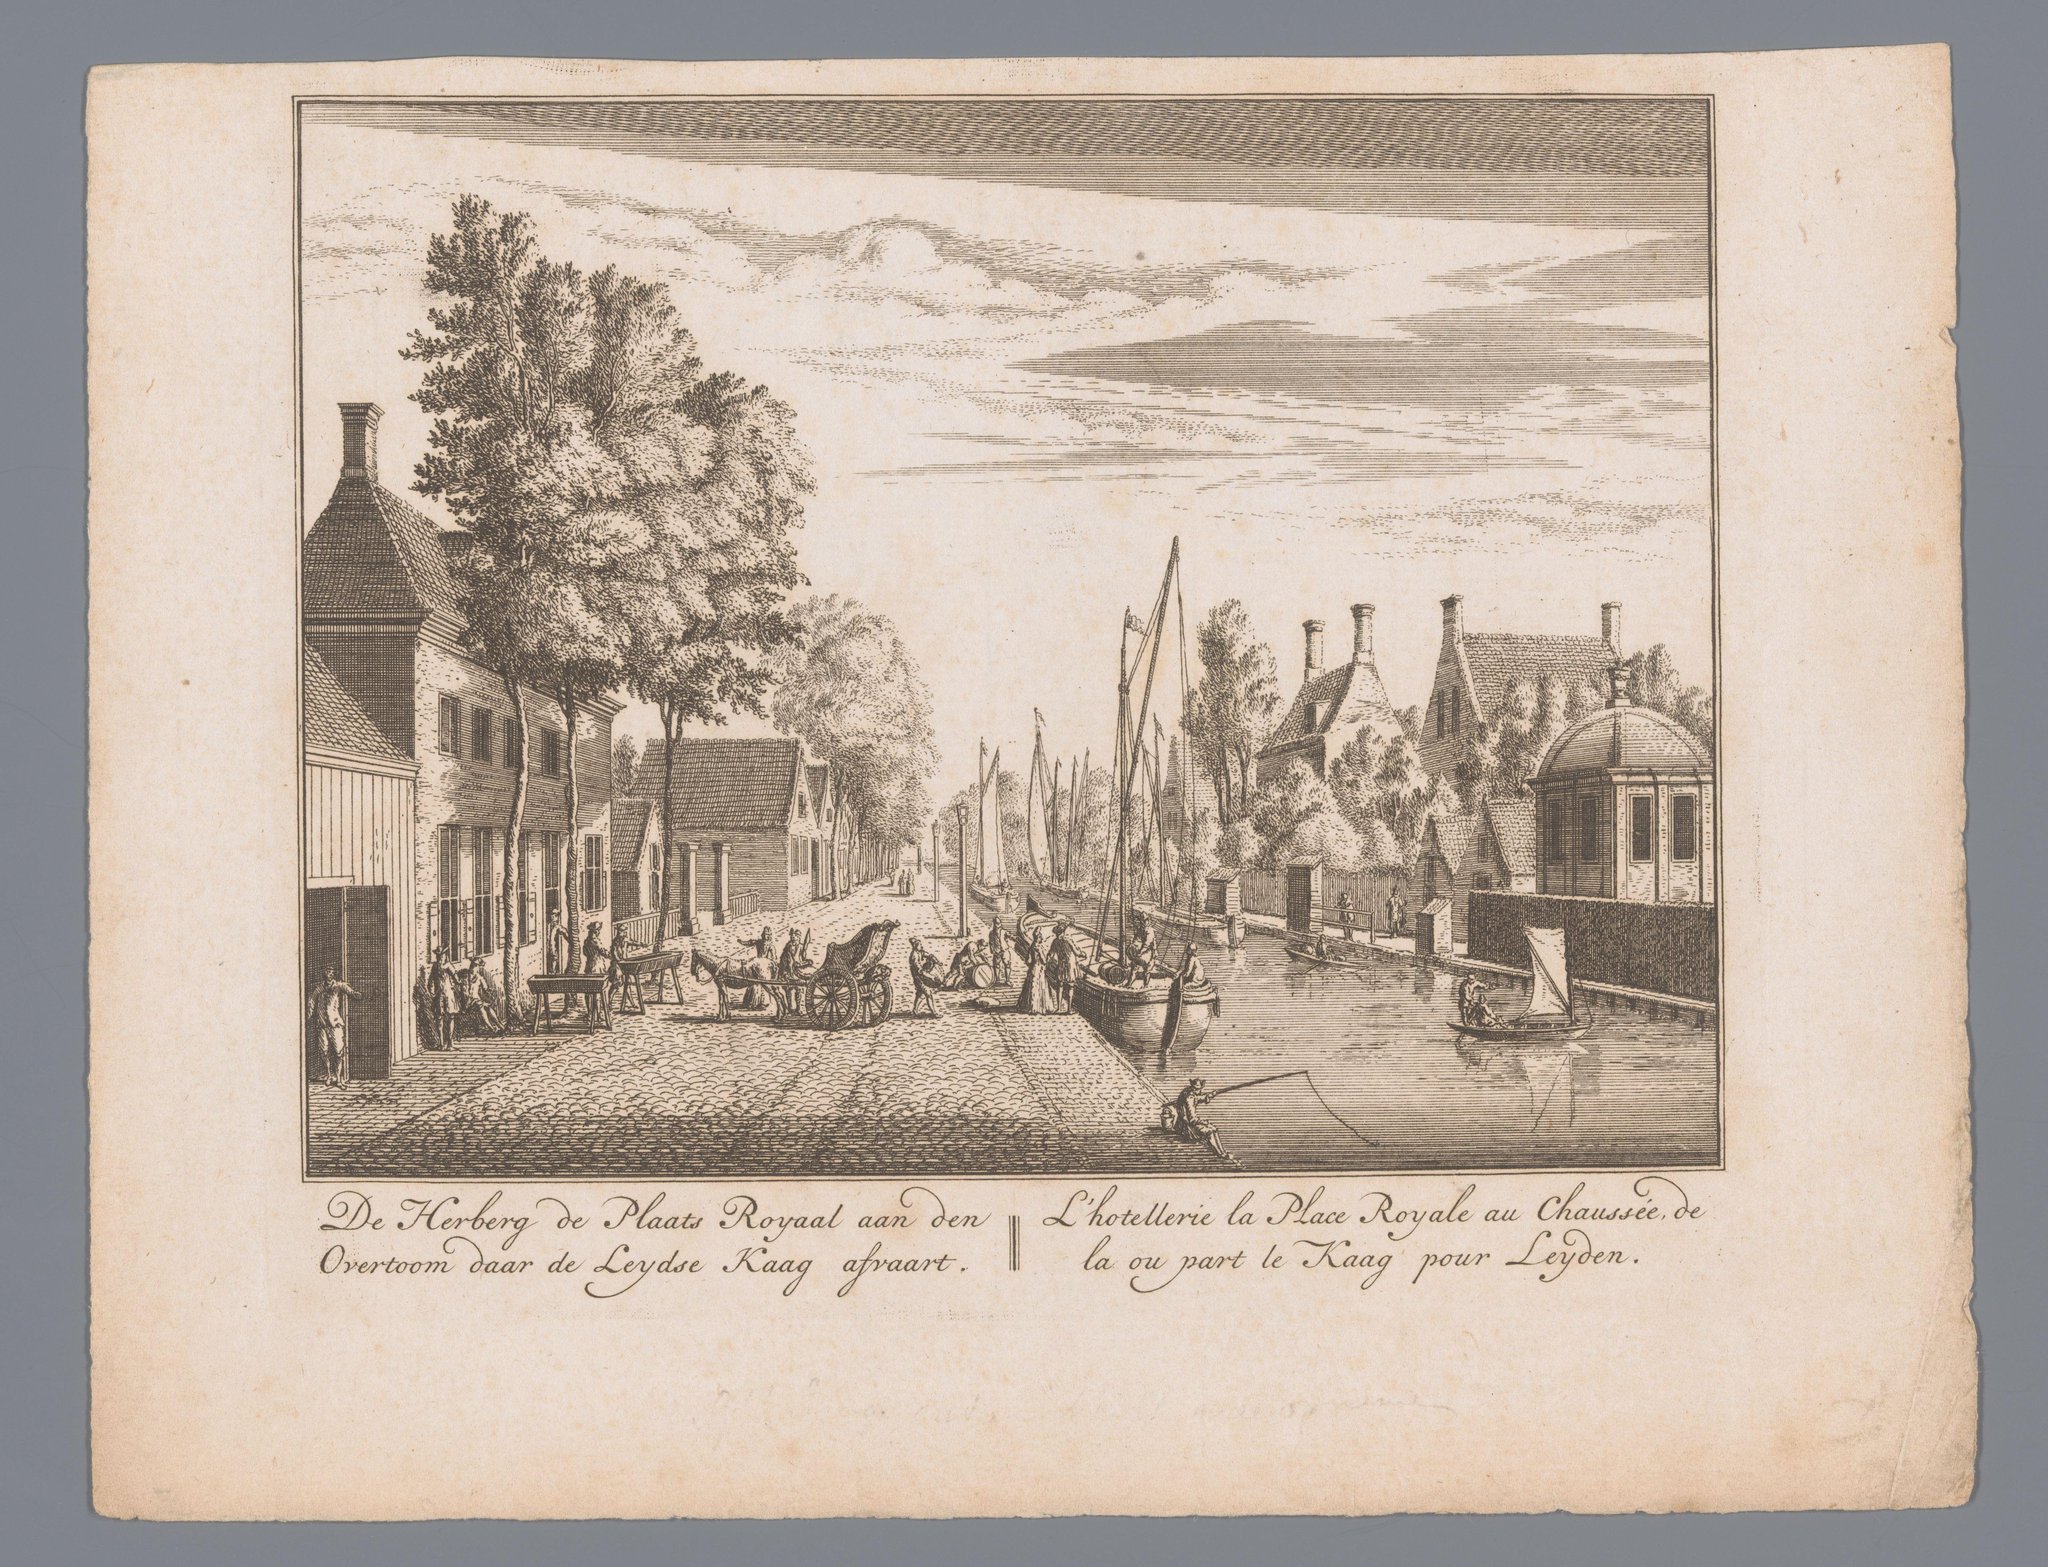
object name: book illustration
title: Spiegel van Amsterdams zomervreugd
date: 1730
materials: paper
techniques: engraving, etching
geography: amsterdam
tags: sailing-ship, sailing-boat, canals, waters (in city), two-wheeled vehicle drawn by one animal, hotel, hostelry, inn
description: Prent uit: Tijssens, G., en Abraham Rademaker. Spiegel van Amsterdams zomervreugd, op de dorpen Amstelveen, Sloten, en den Overtoom (...). Amsterdam: Leonard Schenk, [ca. 1730].